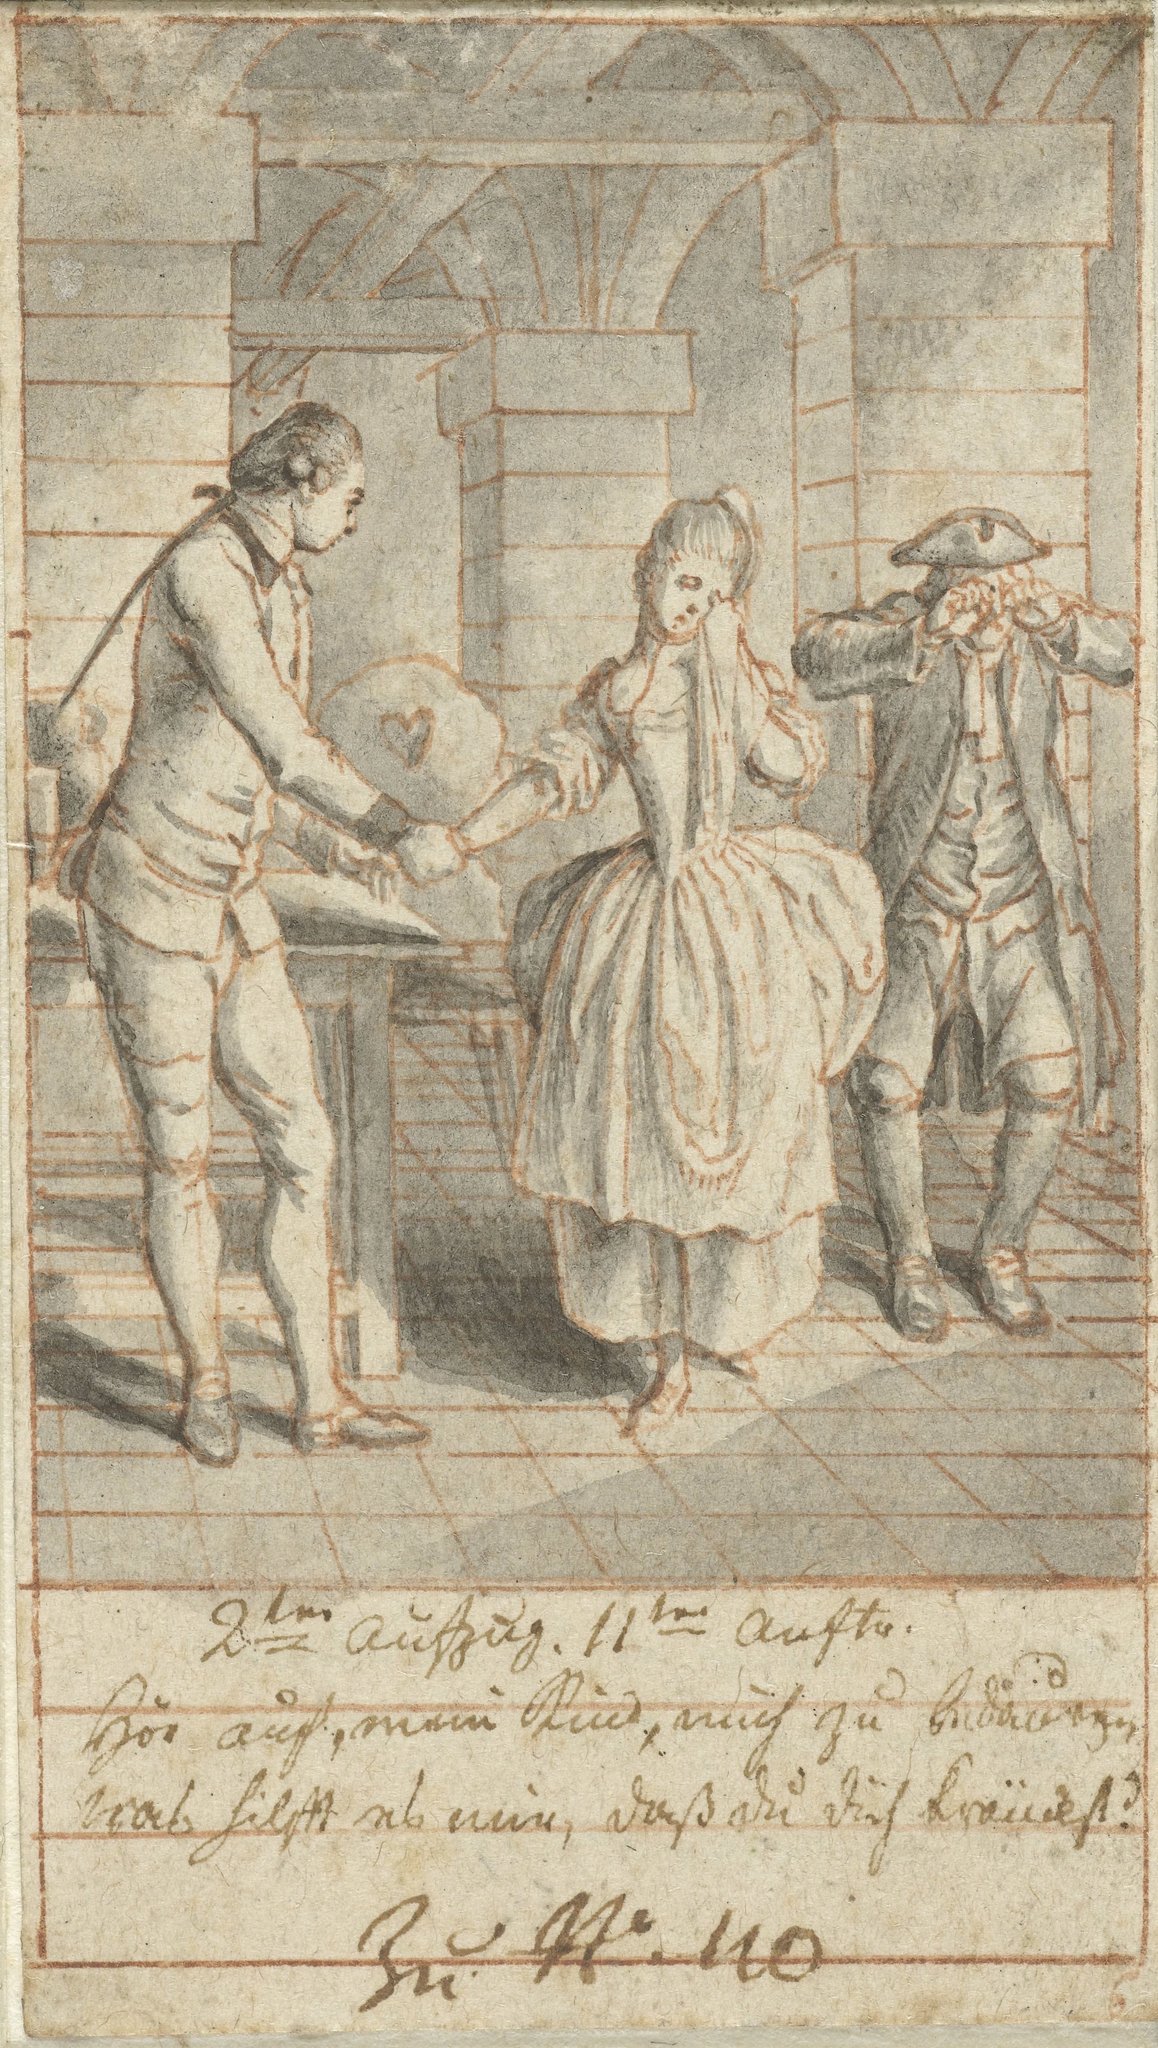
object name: design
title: Ontwerpen voor illustraties voor Le Deserteur van Jean-Michel Sedaine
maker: daniel nikolaus chodowiecki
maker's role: draughtsman, print maker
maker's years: 1726-1801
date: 1770-1775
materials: ink, paper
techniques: brush, pen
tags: prison, jail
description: Illustratie voor 'Le Deserteur' van Jean-Michel Sedaine.